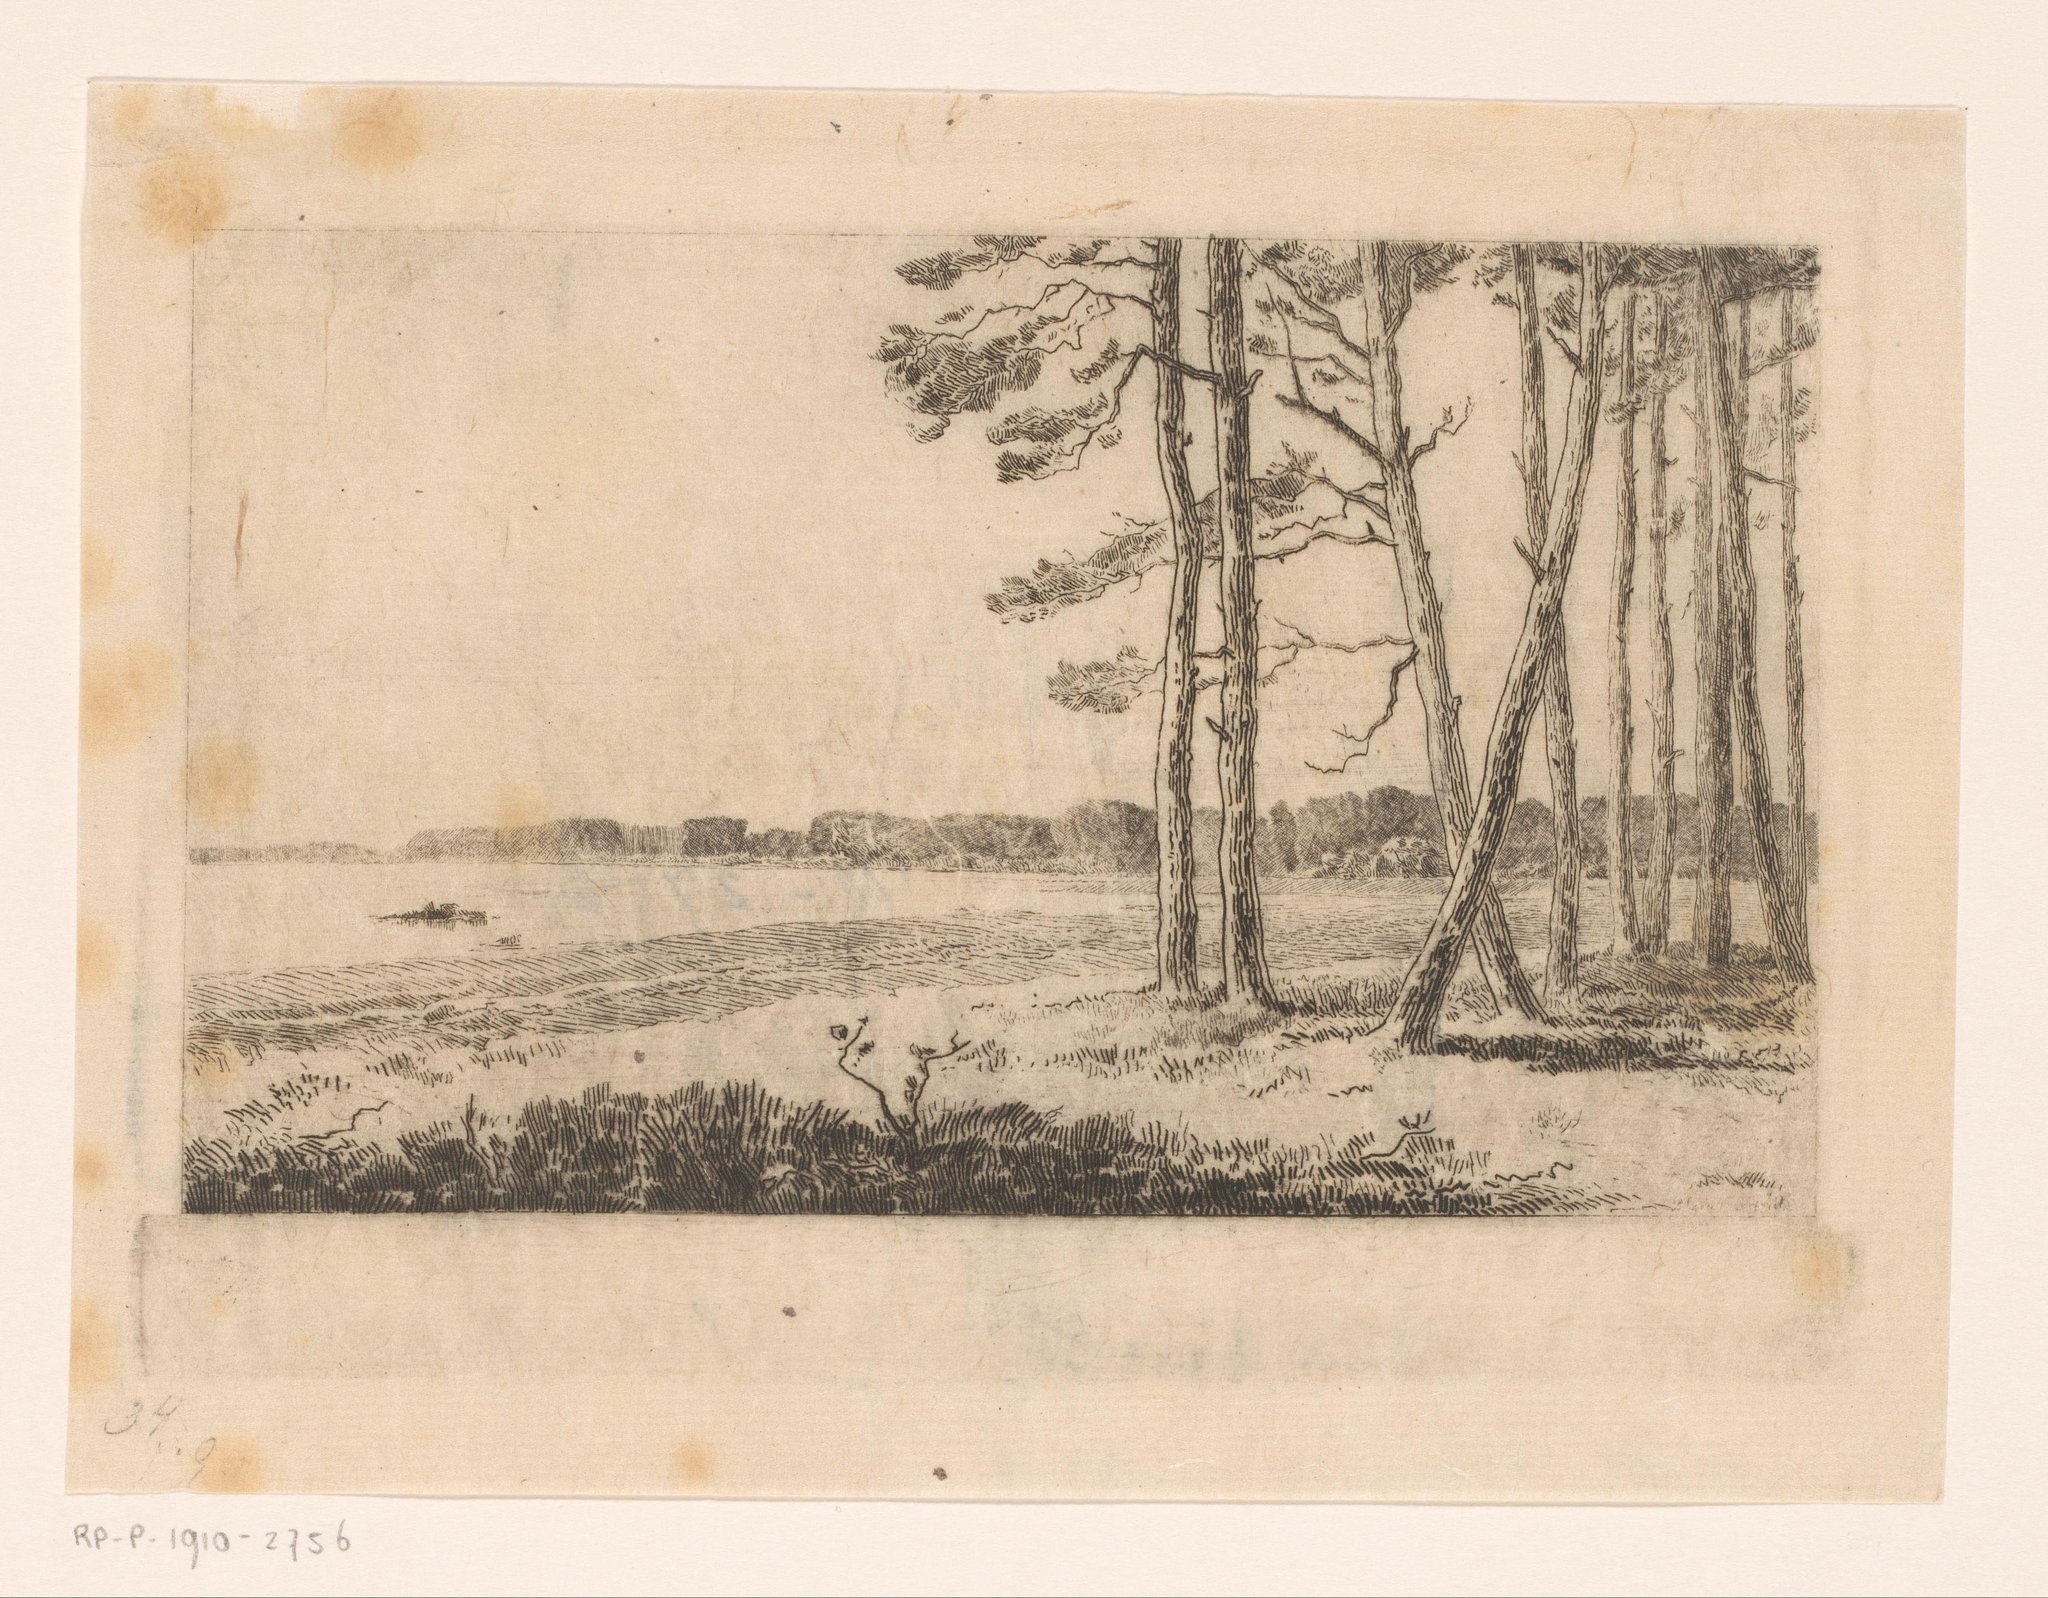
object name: print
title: Bosrand bij Kalmthout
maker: carel nicolaas storm van s-gravesande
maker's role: draughtsman, print maker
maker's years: 1841-1924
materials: paper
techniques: etching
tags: lake, fringe, edge of the wood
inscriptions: collector's mark: Lugt 2228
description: Landschap met bomen aan de rand van een meer.